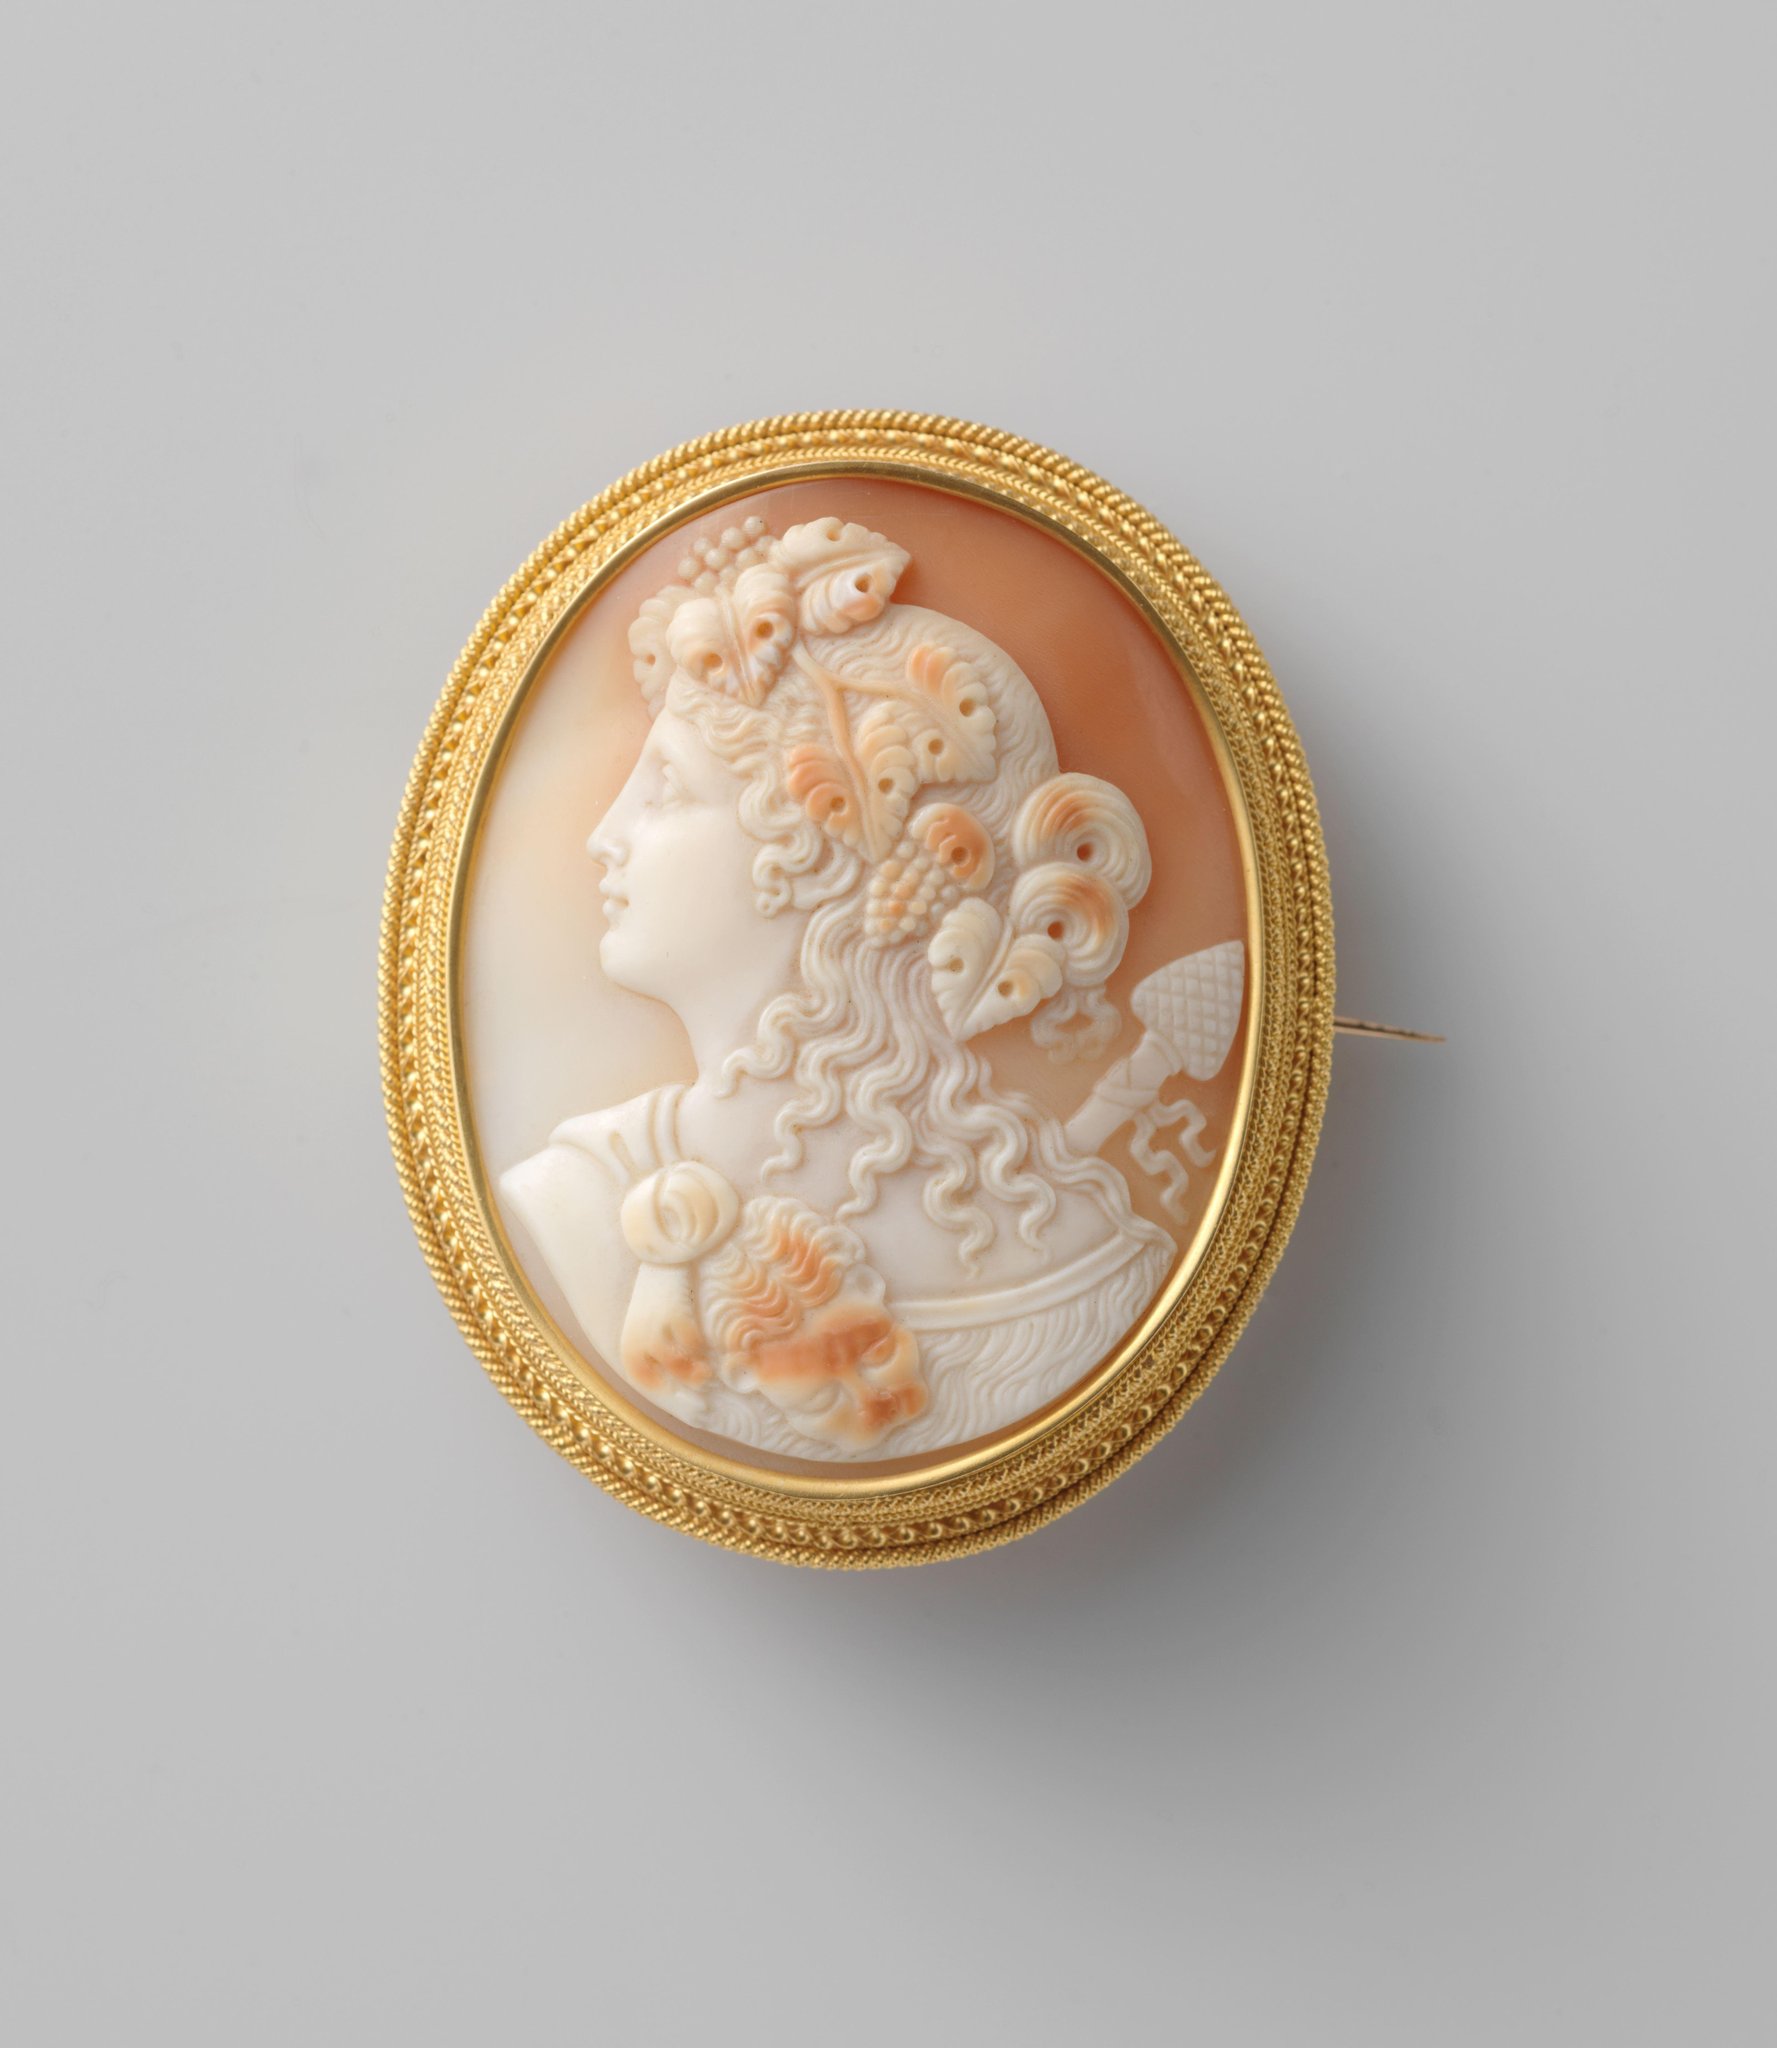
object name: jewellery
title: Broche met camee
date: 1850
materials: gold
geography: netherlands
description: Een broche, camee, voorstellende een Bacchante. In een gouden omlijsting met fijne parel- en kabelrandjes.